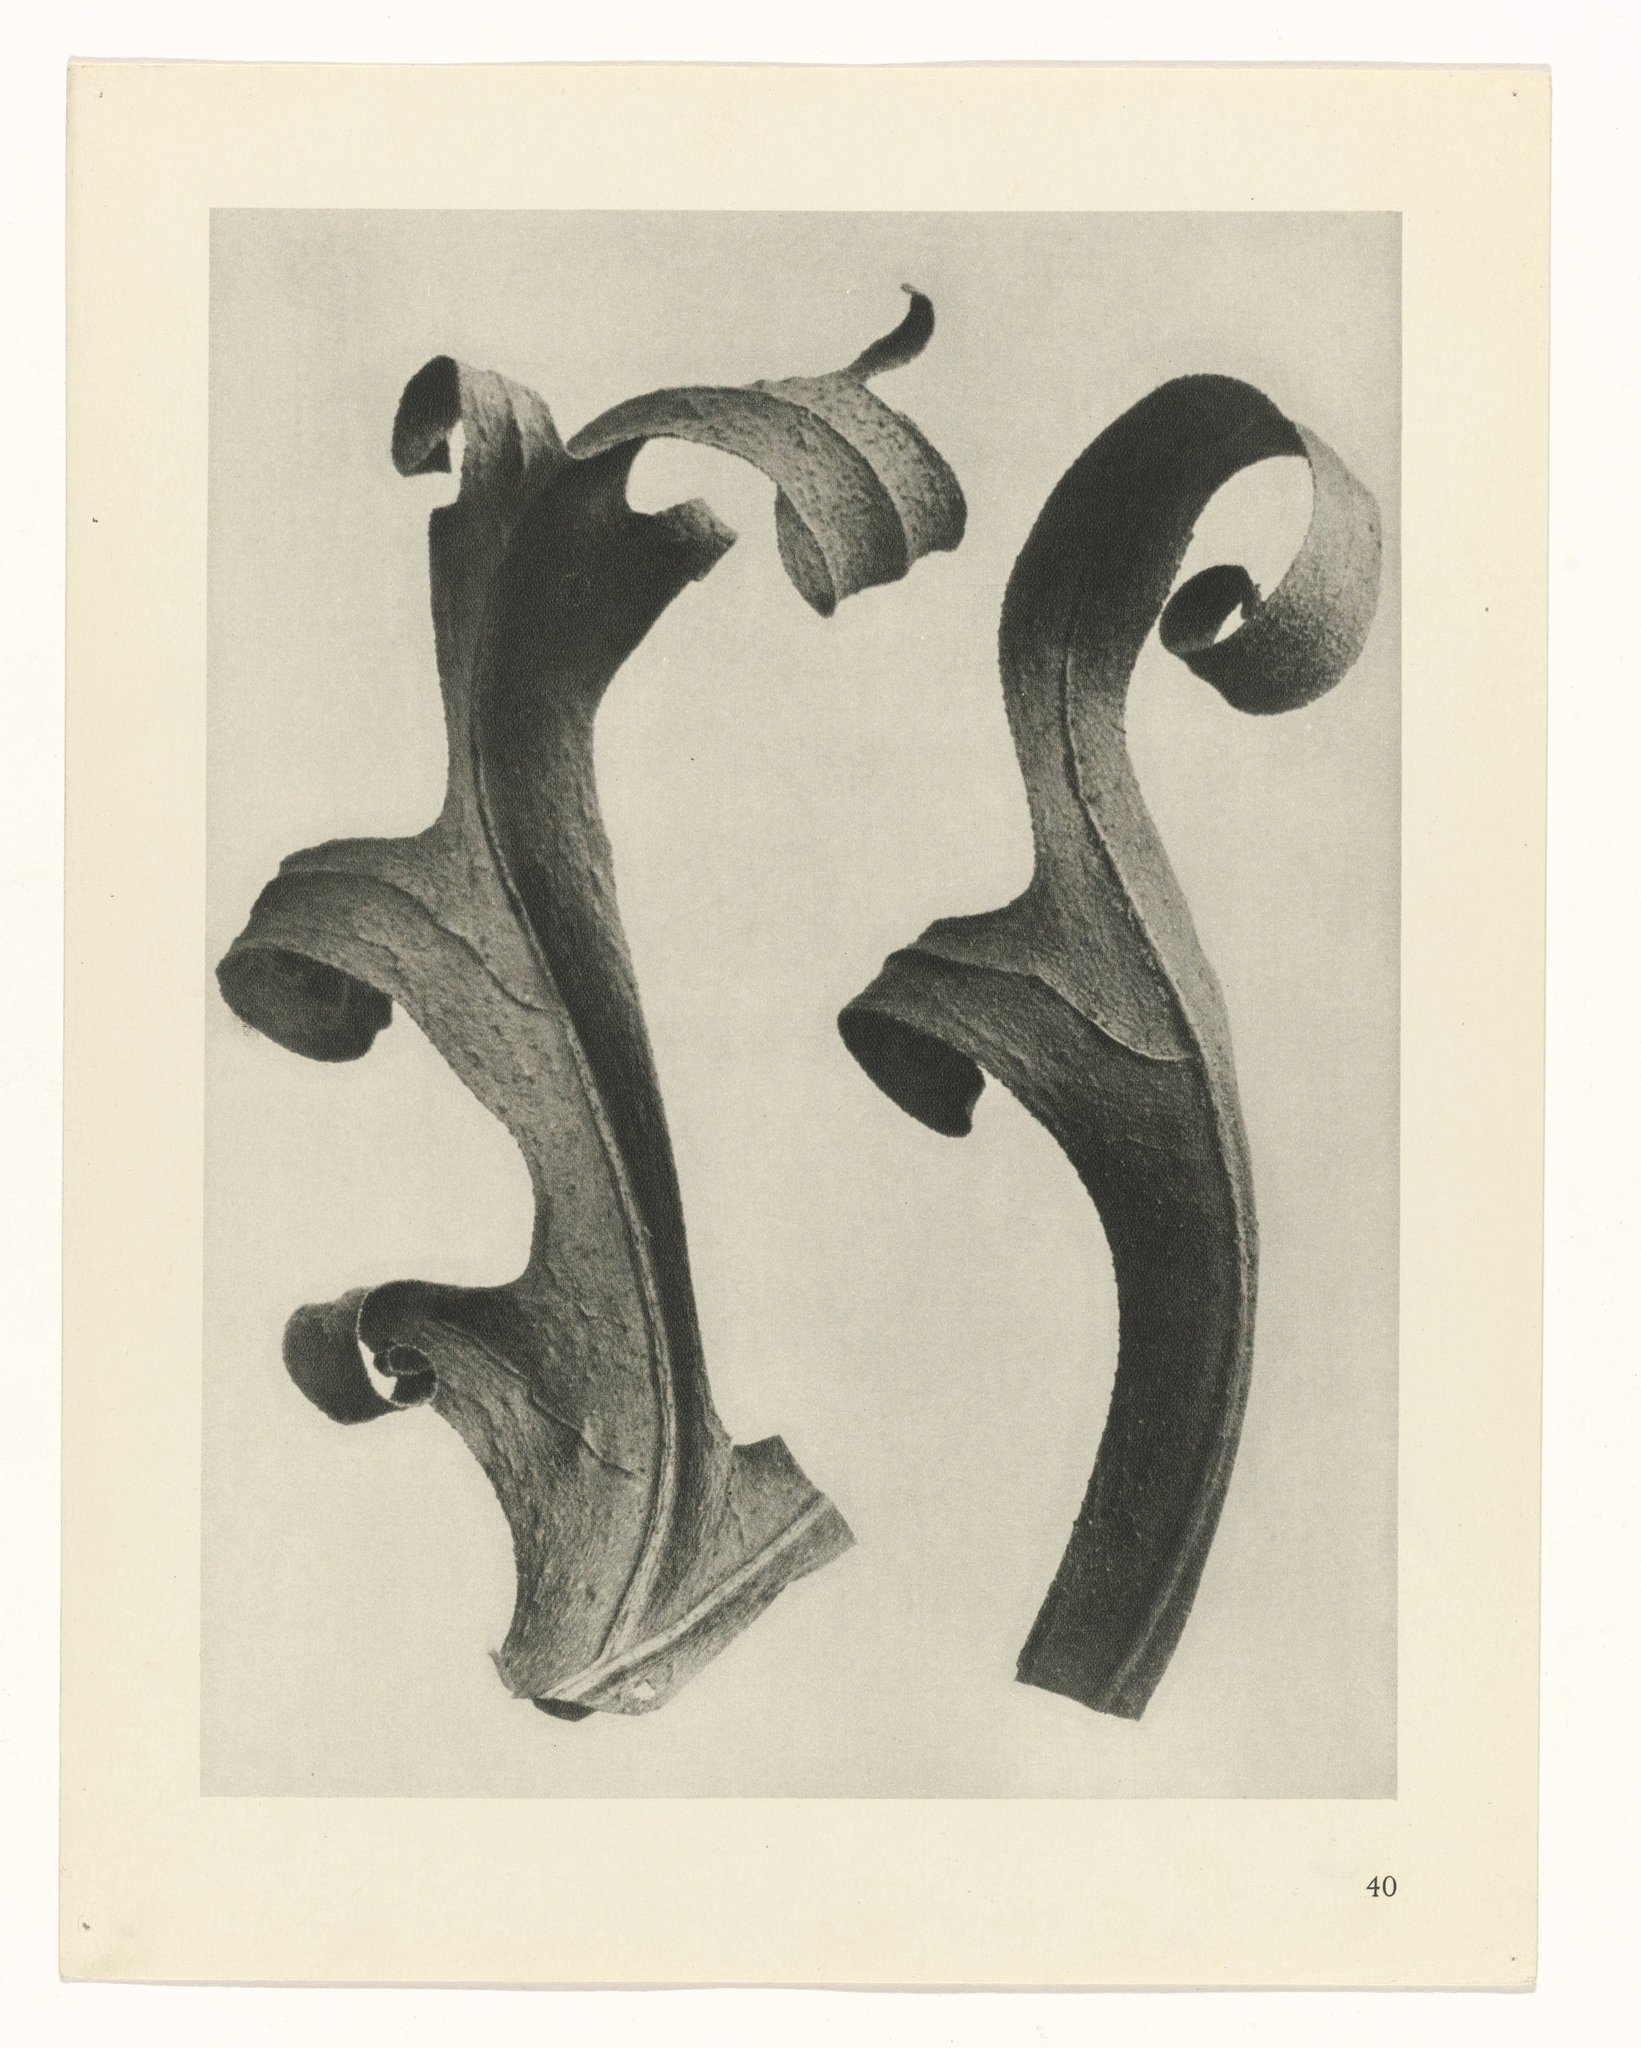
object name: photograph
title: Urformen der Kunst: photographische Pflanzenbilder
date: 1928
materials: ink, paper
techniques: rotogravure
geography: berlin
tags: plants (in general)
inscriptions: number: ‘40’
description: facher Vergrößerung. Afkomstig uit losbladige uitgave.